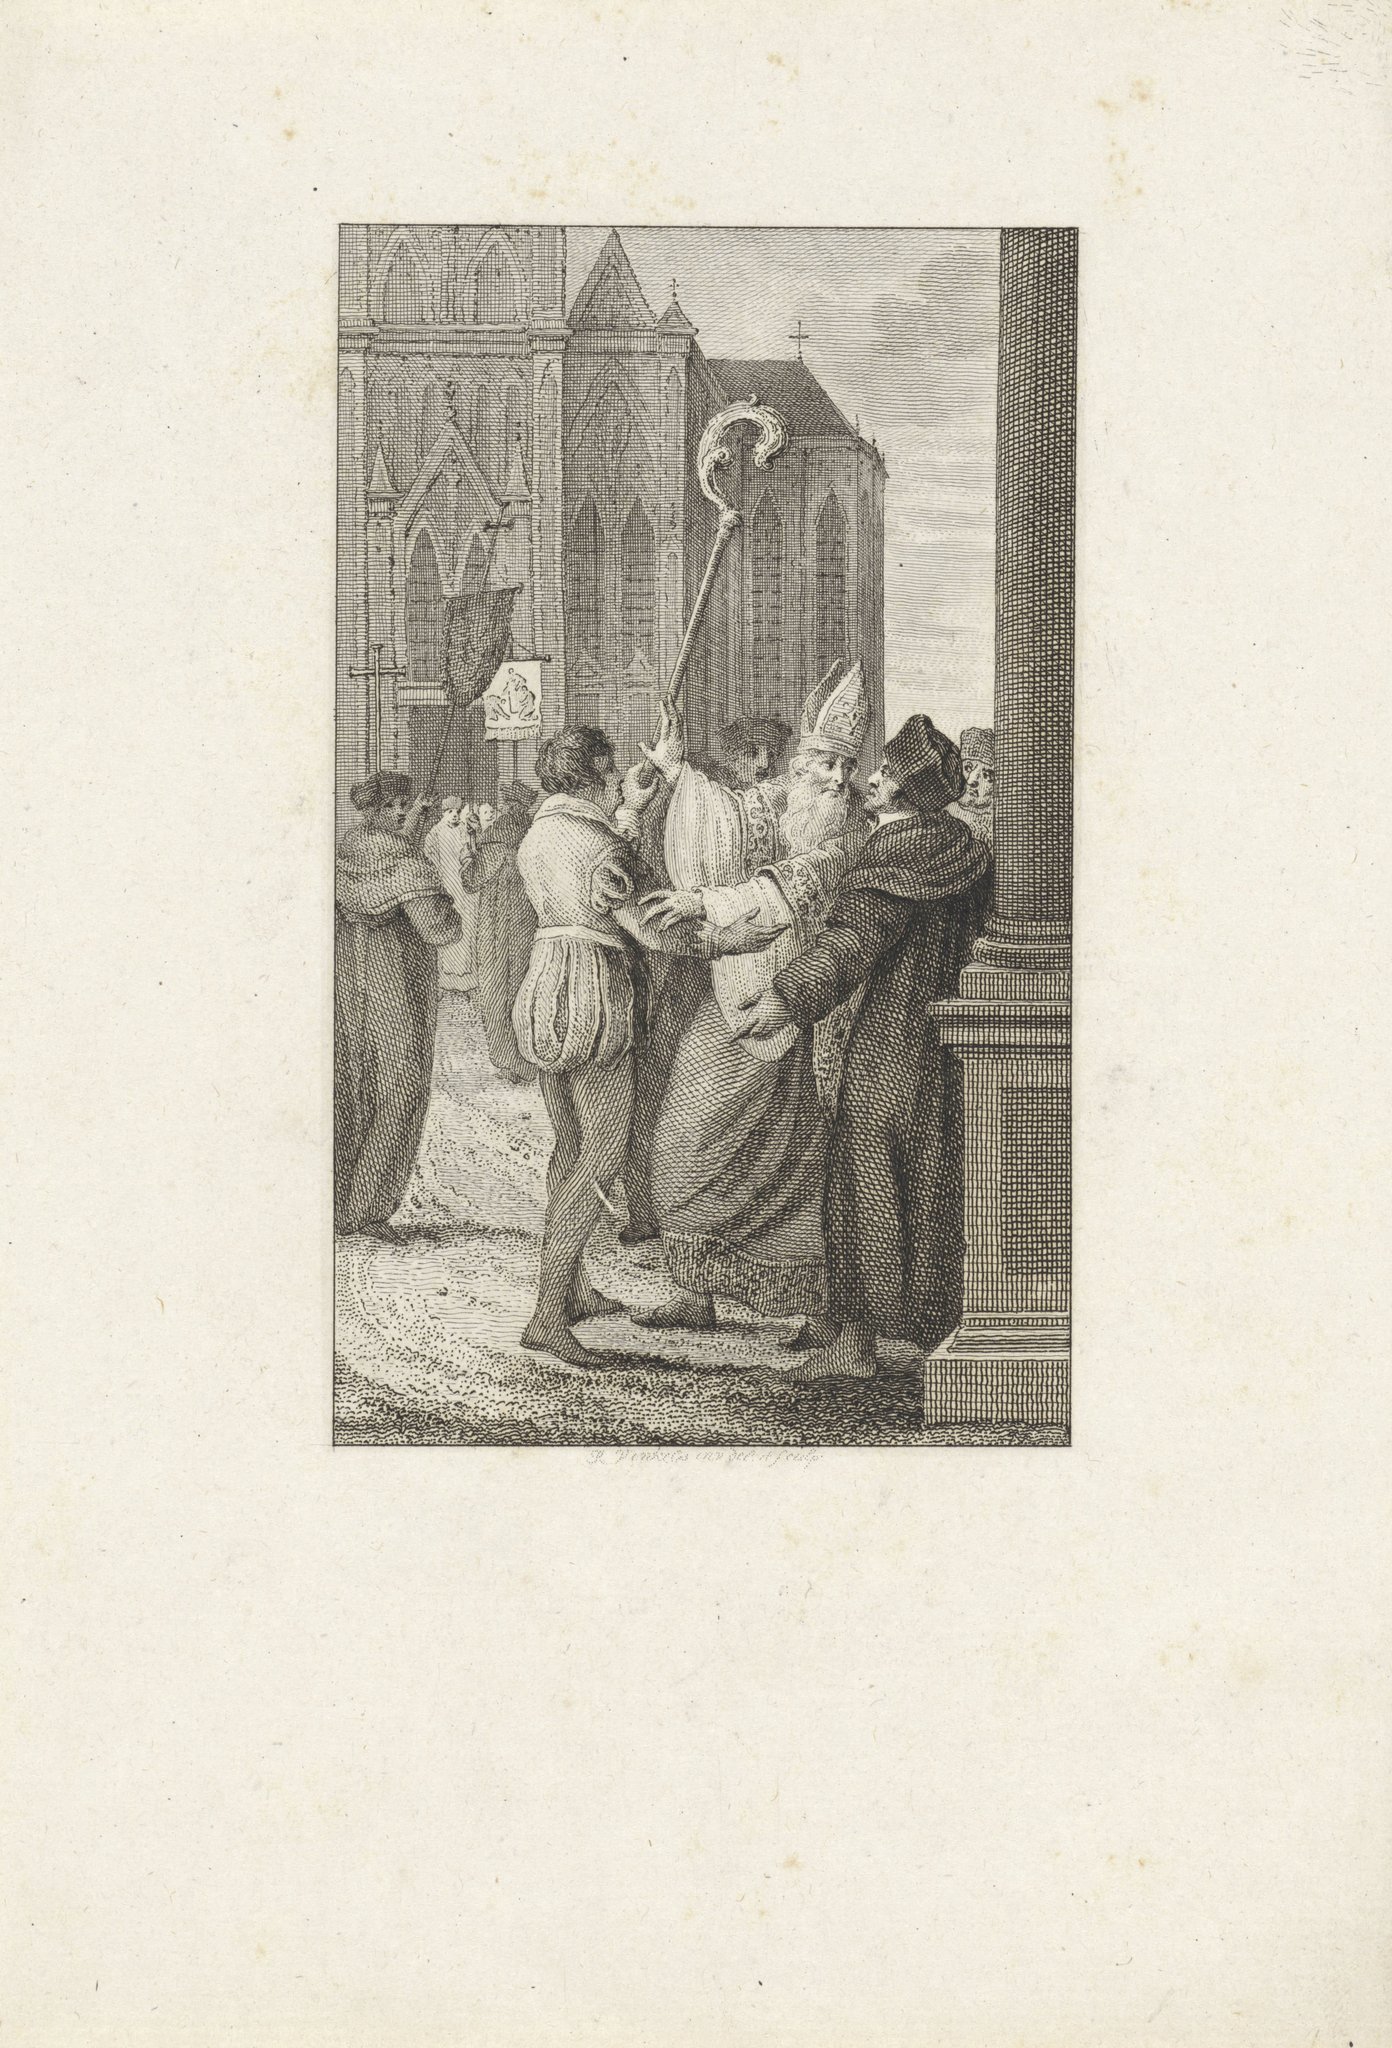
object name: print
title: Anselmus krijgt de bisschopsstaf in zijn handen gedrukt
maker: reinier vinkeles (i)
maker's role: draughtsman, print maker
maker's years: 1741-1816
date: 1807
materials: paper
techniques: engraving, etching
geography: amsterdam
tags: archbishop, bishop, etc. (roman catholic), church (exterior), quarrel, argument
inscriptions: collector's mark: Lugt 2228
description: Proefdruk van een illustratie in: Hamelsveld, Ysbrand van. Algemeene kerkelijke geschiedenis, der Christenen, deel 15. Haarlem: François Bohn, 1807, p. 74.